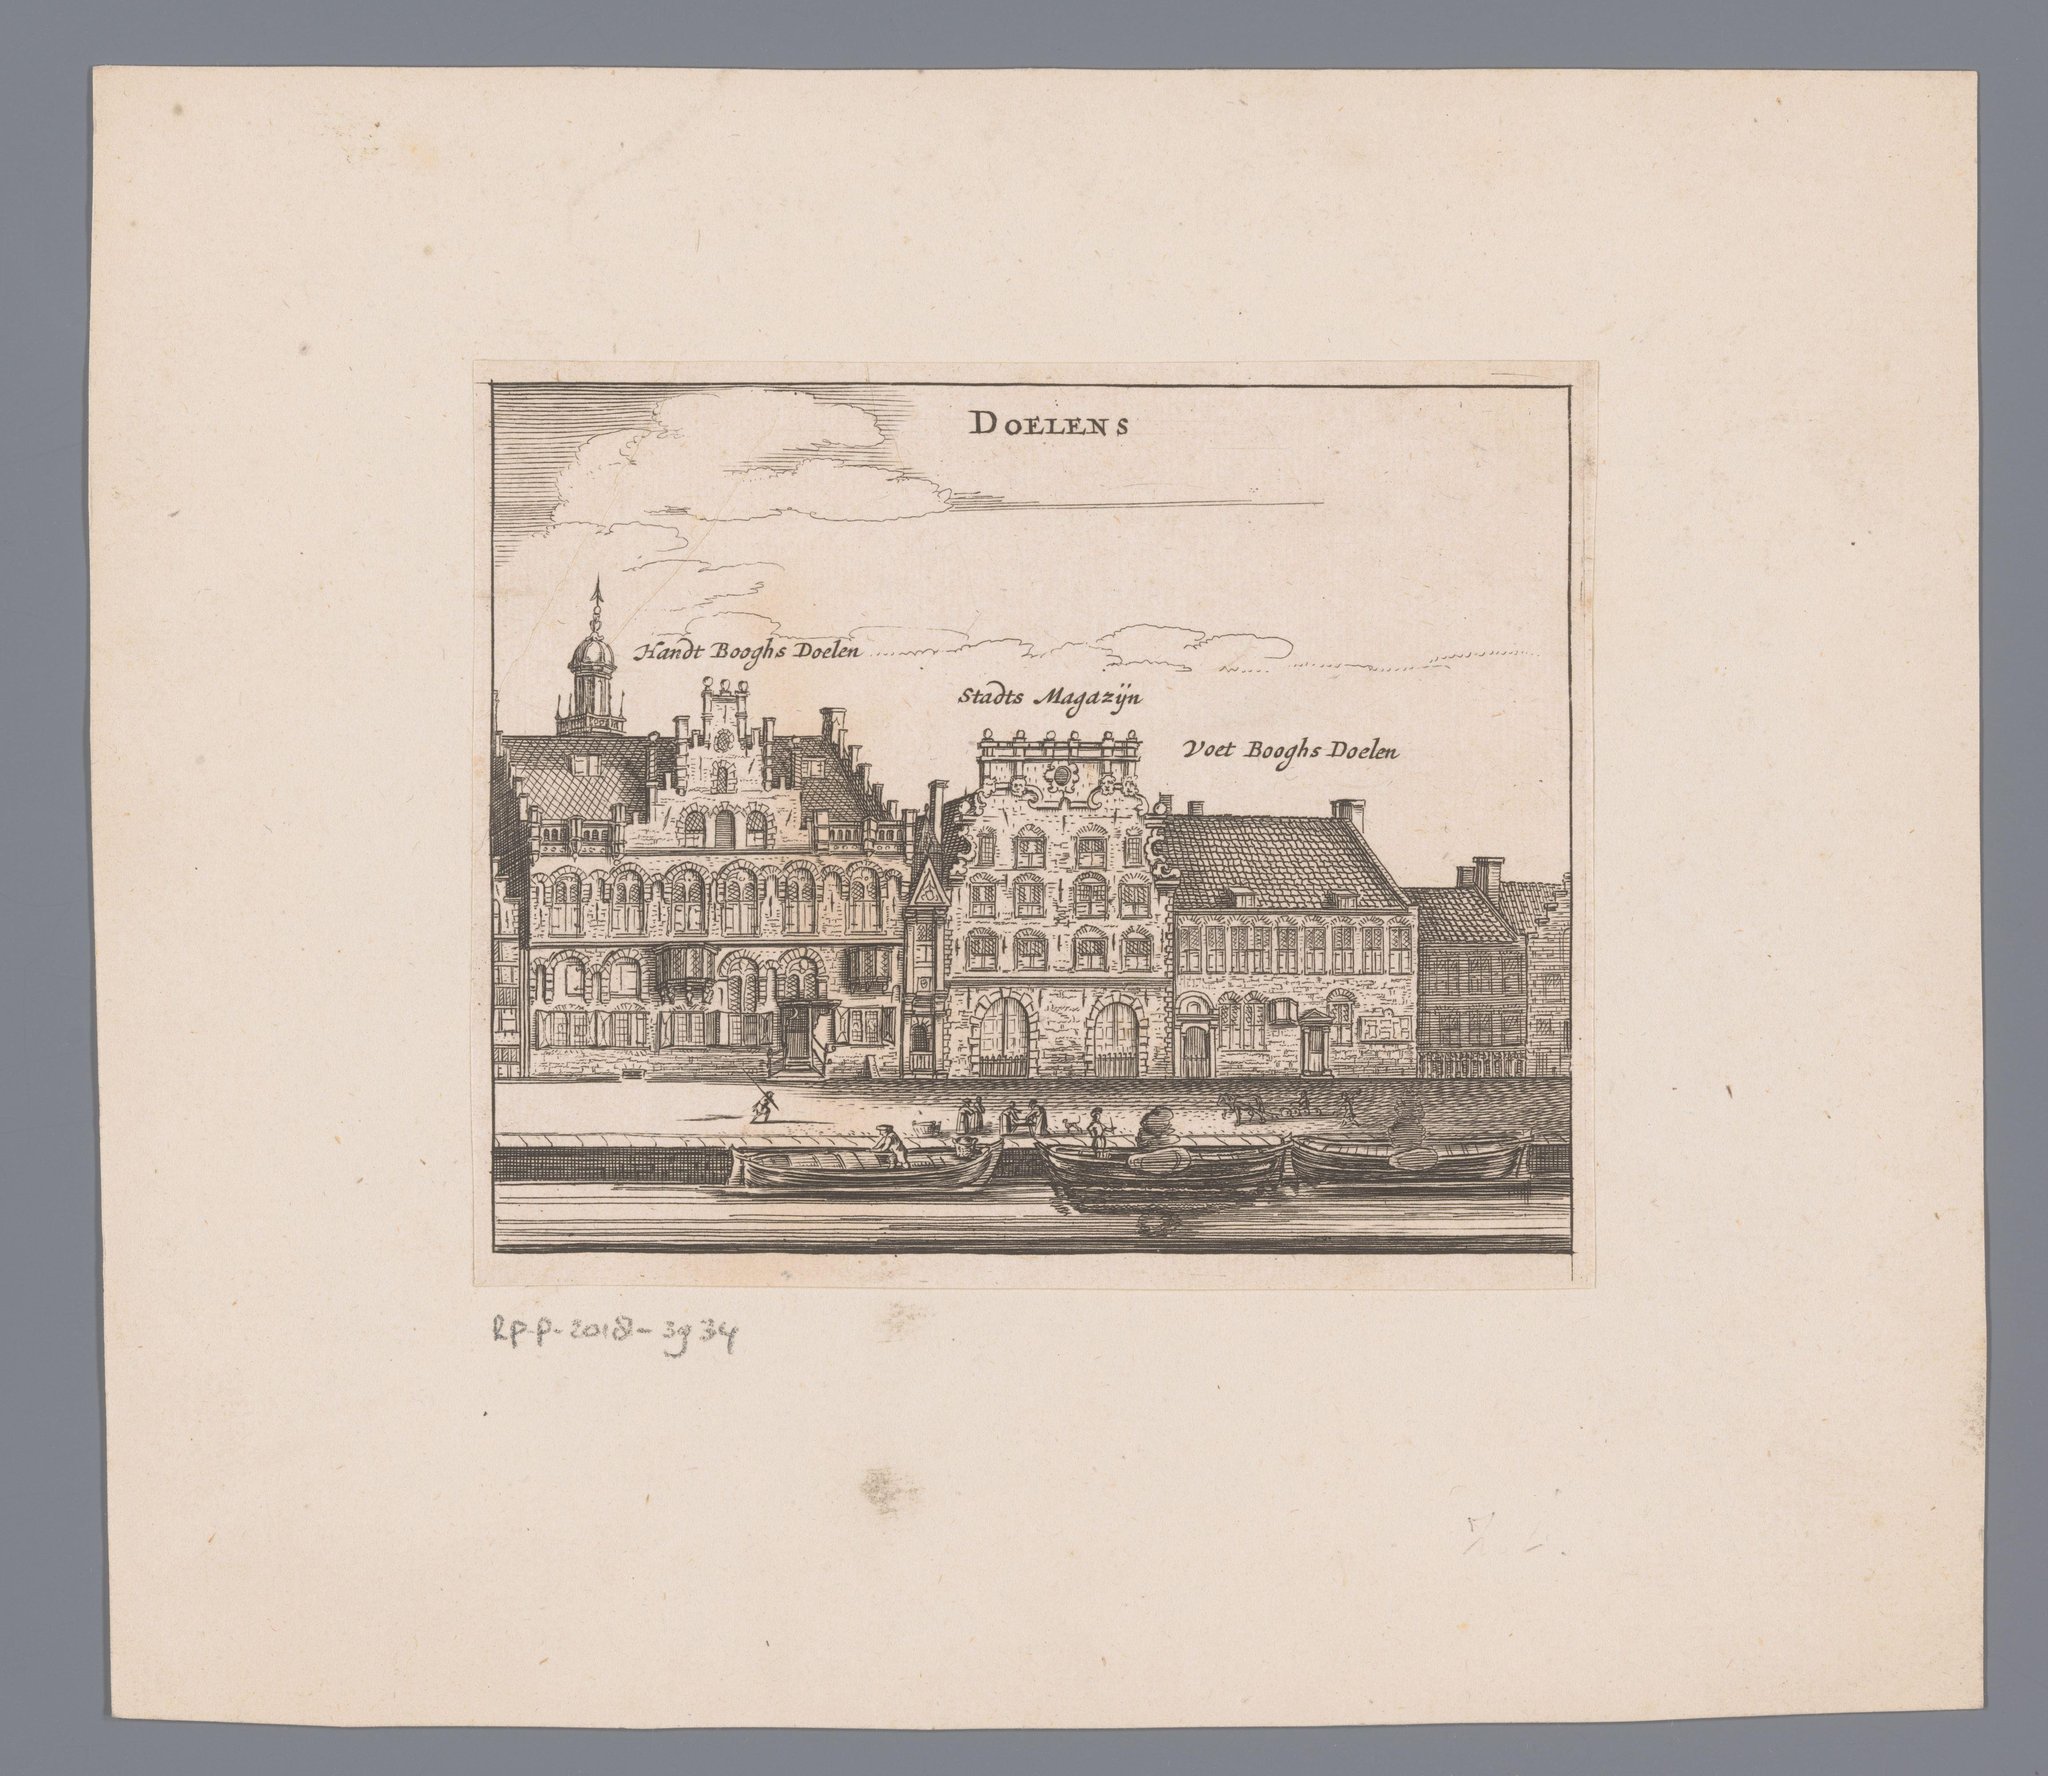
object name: print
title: Doelens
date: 1664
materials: paper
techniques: etching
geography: amsterdam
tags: civic architecture; edifices; dwellings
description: Huidige staat van prent ook gebruikt in: Fockens, Melchior. Beschrijving Der wijdt-vermaarde Koop-stadt Amstelredam, Van haar eerste beginselen, zedert den Jare 1203. oude Voorrechten, verscheyde Vergrootingenoude Voor-rechten, en verscheyde Vergrootingen (…). 3e druk. Amsterdam: Marcus Willemsz. Doornick, 1664. En in: Zesen, Philipp von. Beschrybung der Weidtberuhmde Kauf-Stadt Amstelredam / Beschreibung der Stadt Amsterdam darinnen von derselben ersten ursprunge bis auf gegenwartigen zustand (…). Amsterdam: Marcus Willemsz. Doornick, 1664. Tweede bekende staat (met toevoeging Franse titel) ook gebruikt in: Domselaer, Tobias en Isaac Commelin. Beschryvinge van Amsterdam : haar eerste oorspronk uyt den huyze der heeren van Aemstel en Aemstellant (…). 6 dln. Amsterdam: Marcus Willemsz van Doornick, 1665. Derde bekende staat (rechtsboven genummerd: 48) ook gebruikt in verschillende latere zeventiende- en achttiende-eeuwse publicaties.